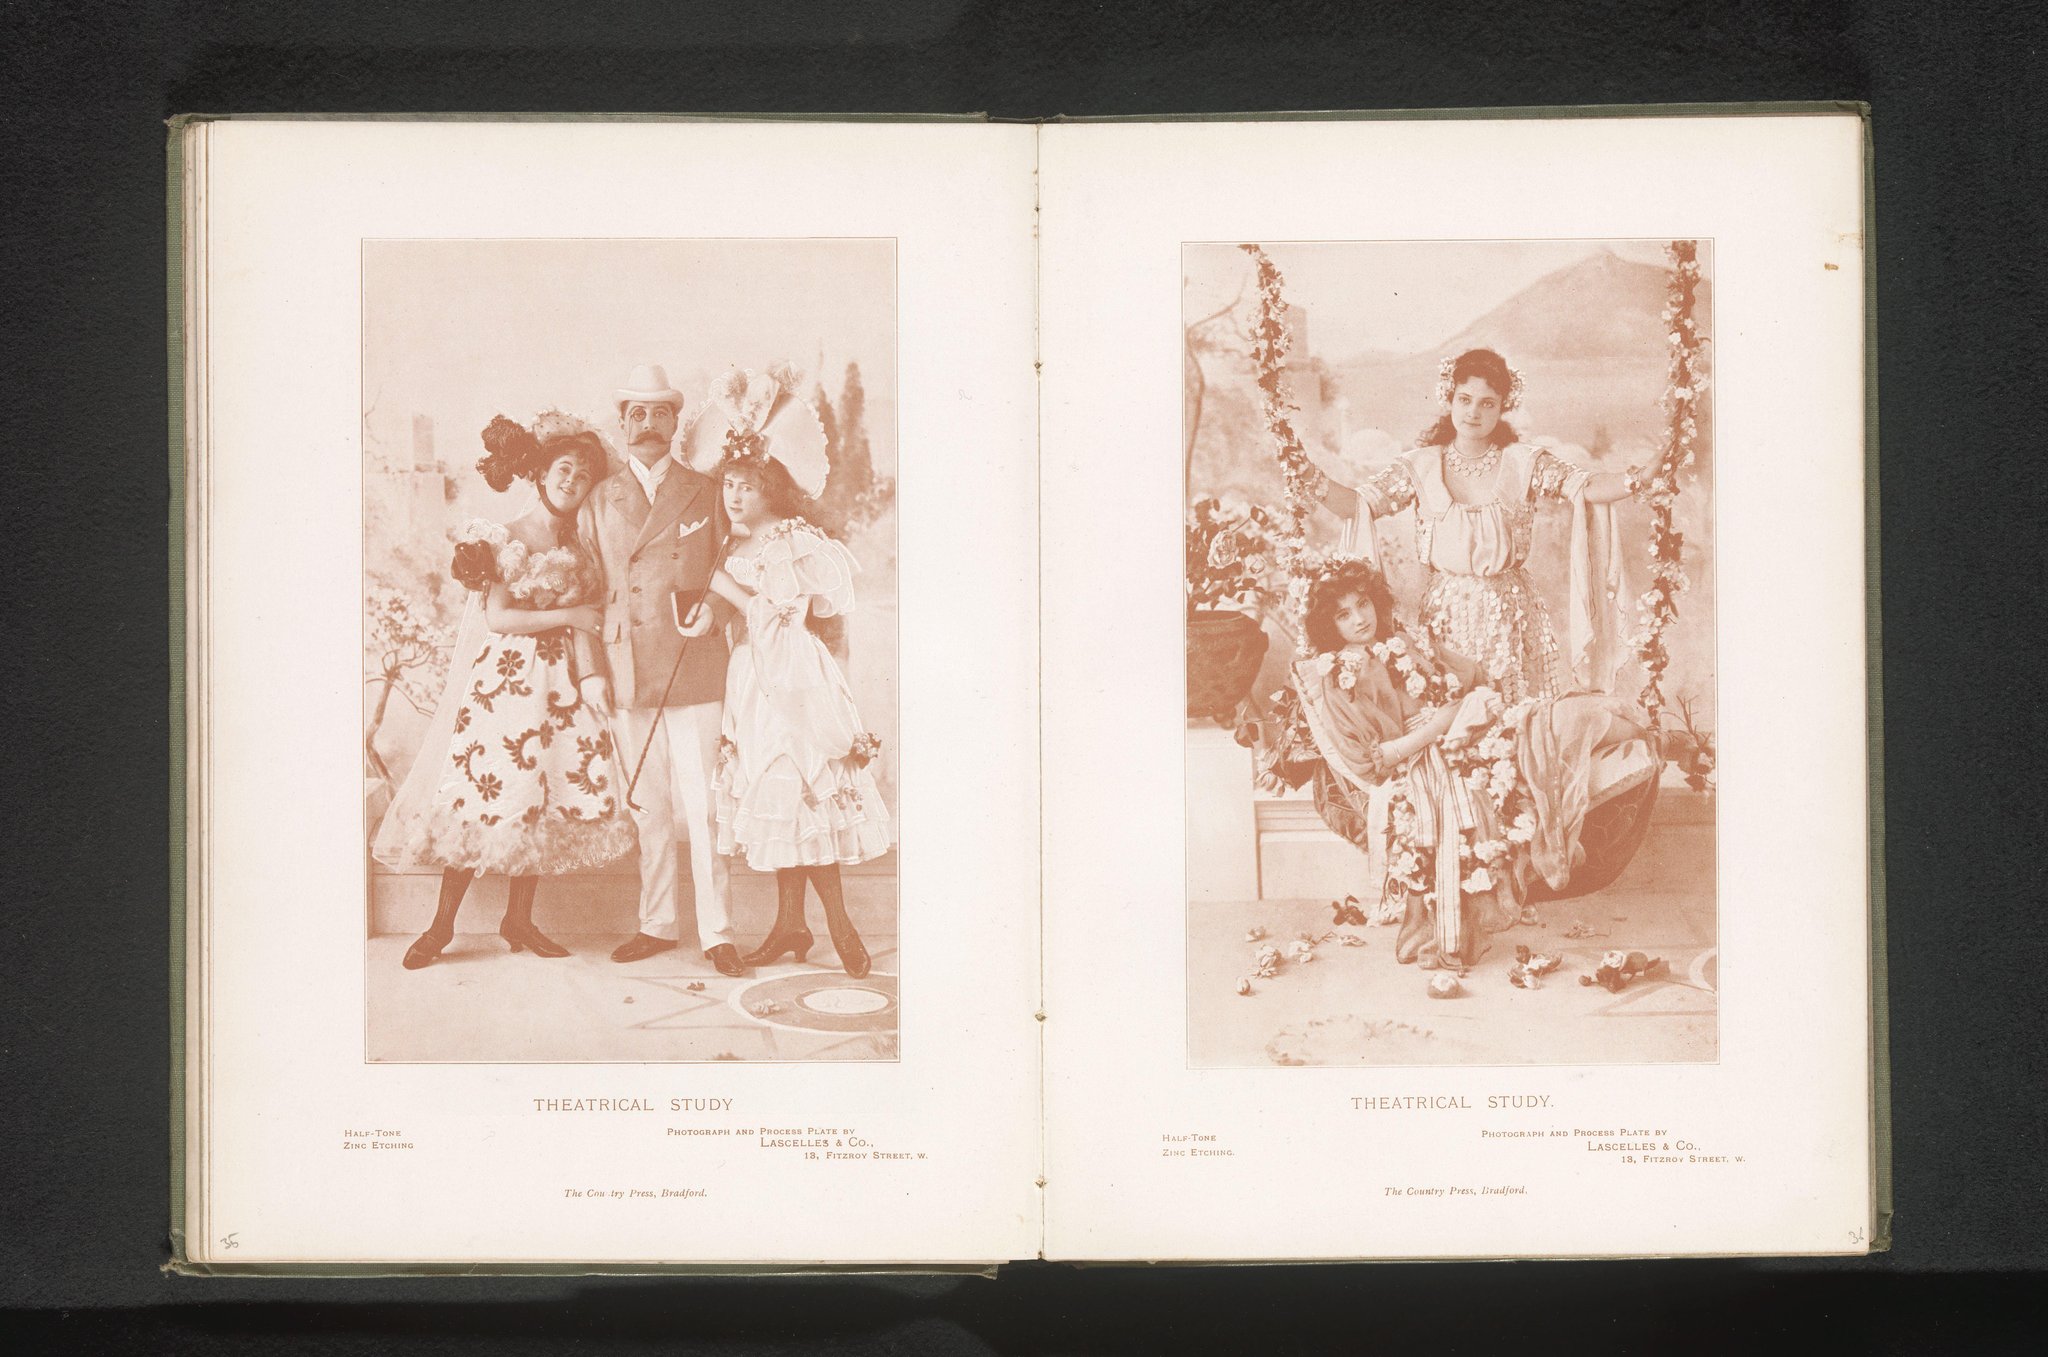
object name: page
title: Portretstudie van een theatergezelschap in kostuum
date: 1893-1898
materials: paper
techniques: autotype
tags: portrait of actor, actress, anonymous historical persons portrayed in a group, in a group-portrait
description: Prent op tweede ongenummerde pagina na pagina 40.